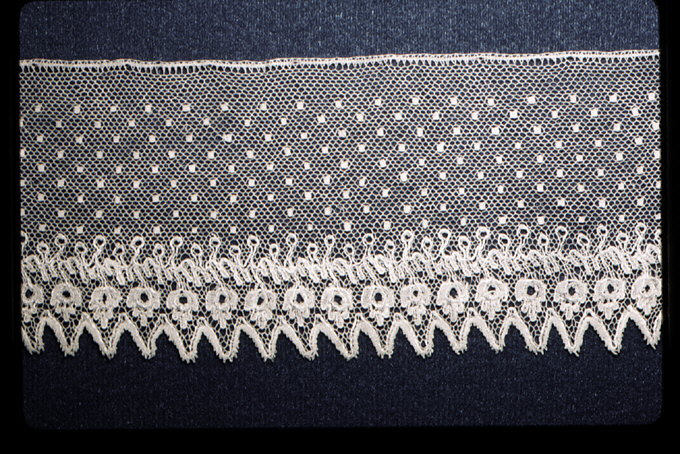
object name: fragment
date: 1810